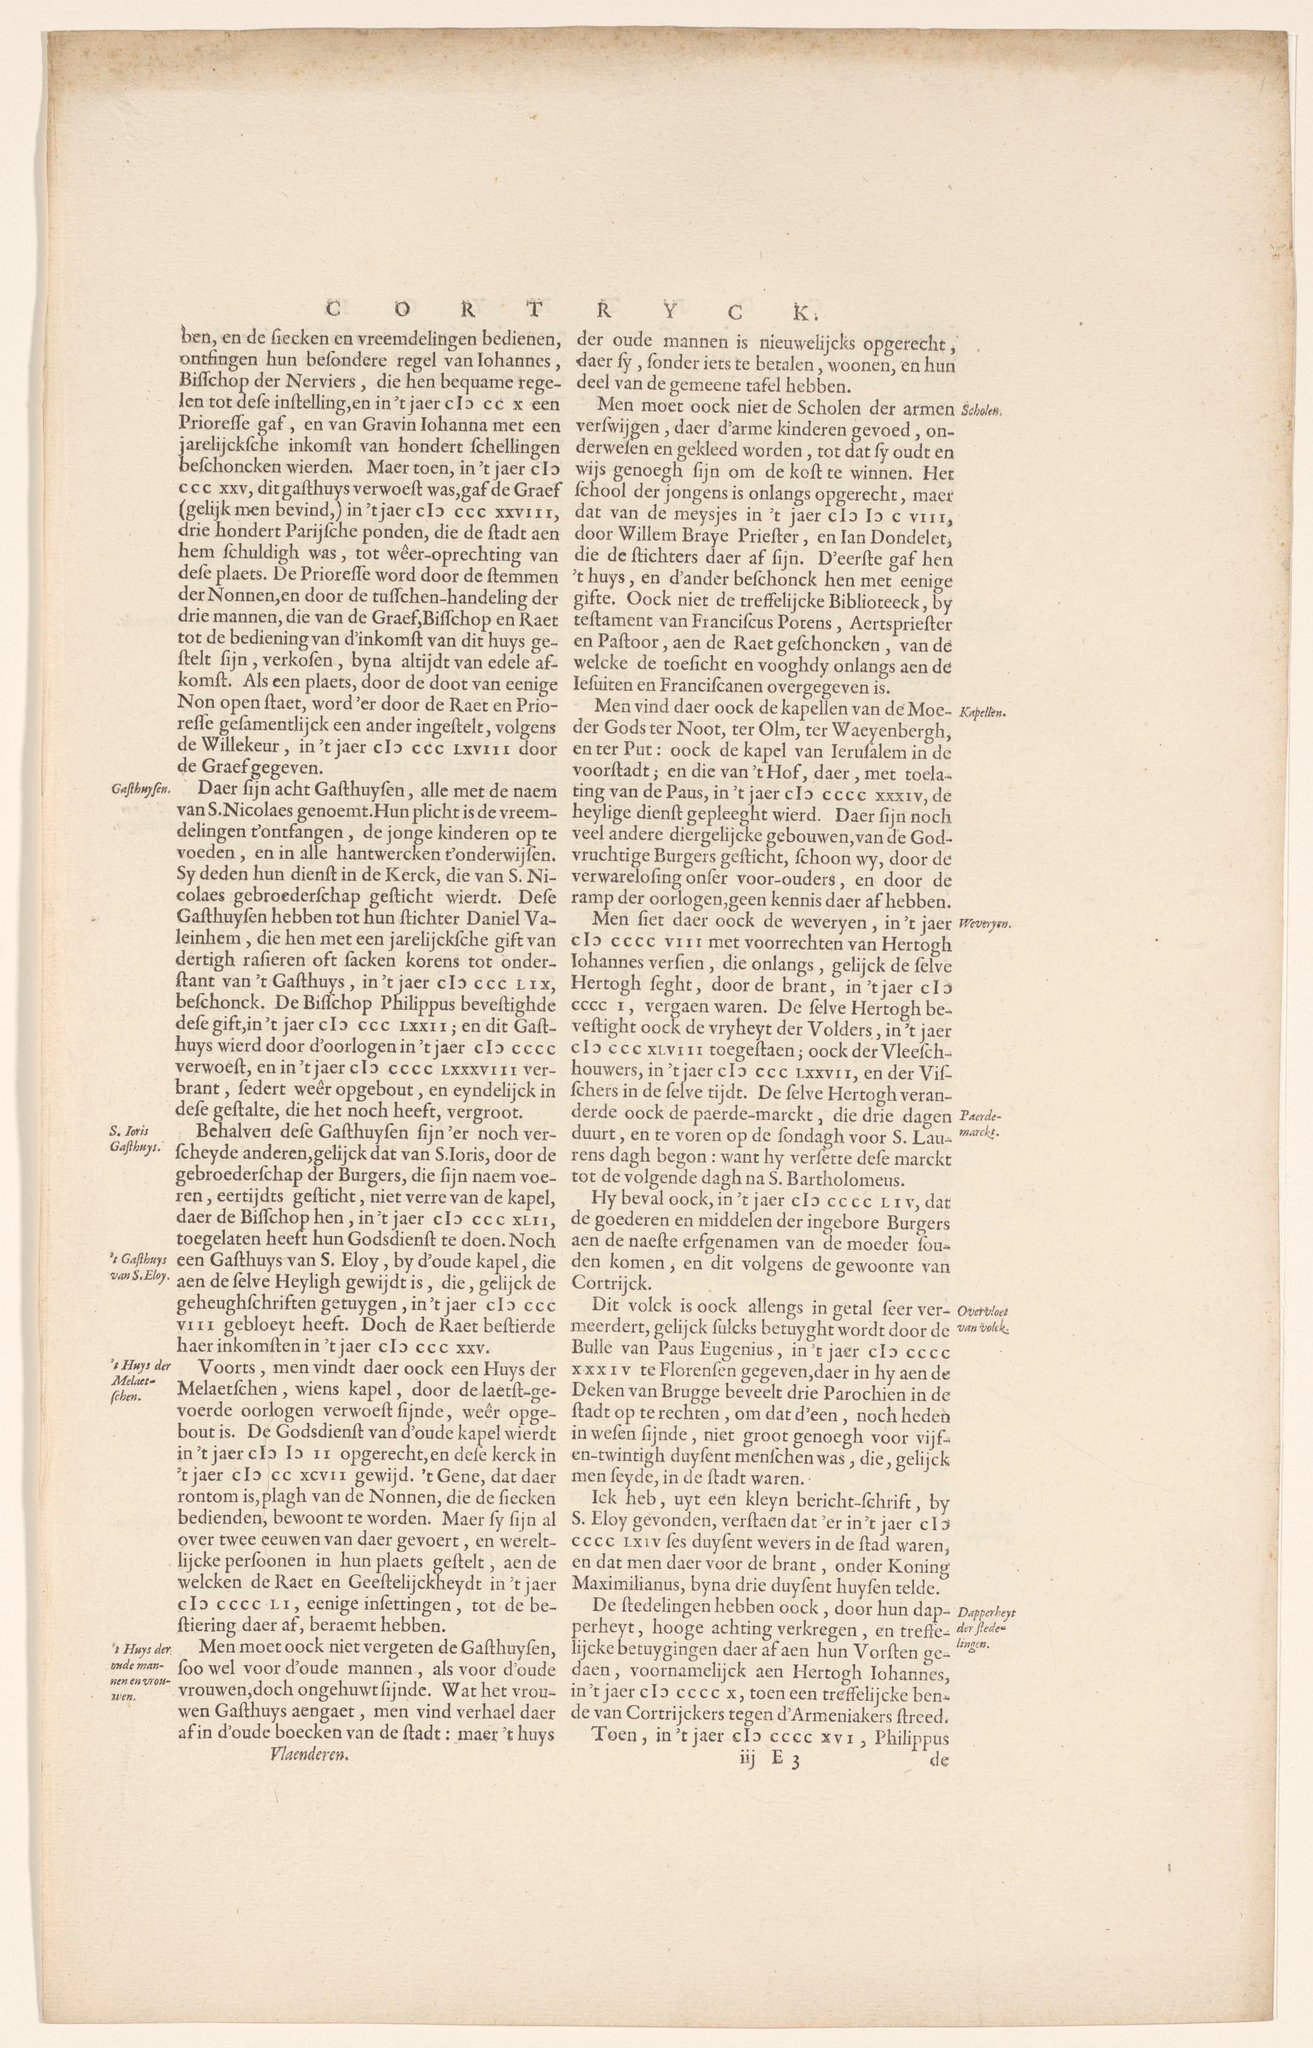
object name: text sheet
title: Deel van de beschrijving van Kortrijk en de citadel van Kortrijk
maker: johannes willemszoon blaeu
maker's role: printer, publisher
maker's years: 1596-1673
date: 1652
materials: paper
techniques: letterpress printing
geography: amsterdam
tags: kortrijk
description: Tekst gebruikt in: Blaeu, Johannes Willemszoon. Toonneel der steden van de Vereenighde Nederlanden. 2 delen. Amsterdam: Johannes Willemszoon Blaeu, 1652, dl. 2. Zie ook: RP-P-AO-18-206-1 en RP-P-AO-18-206-4.